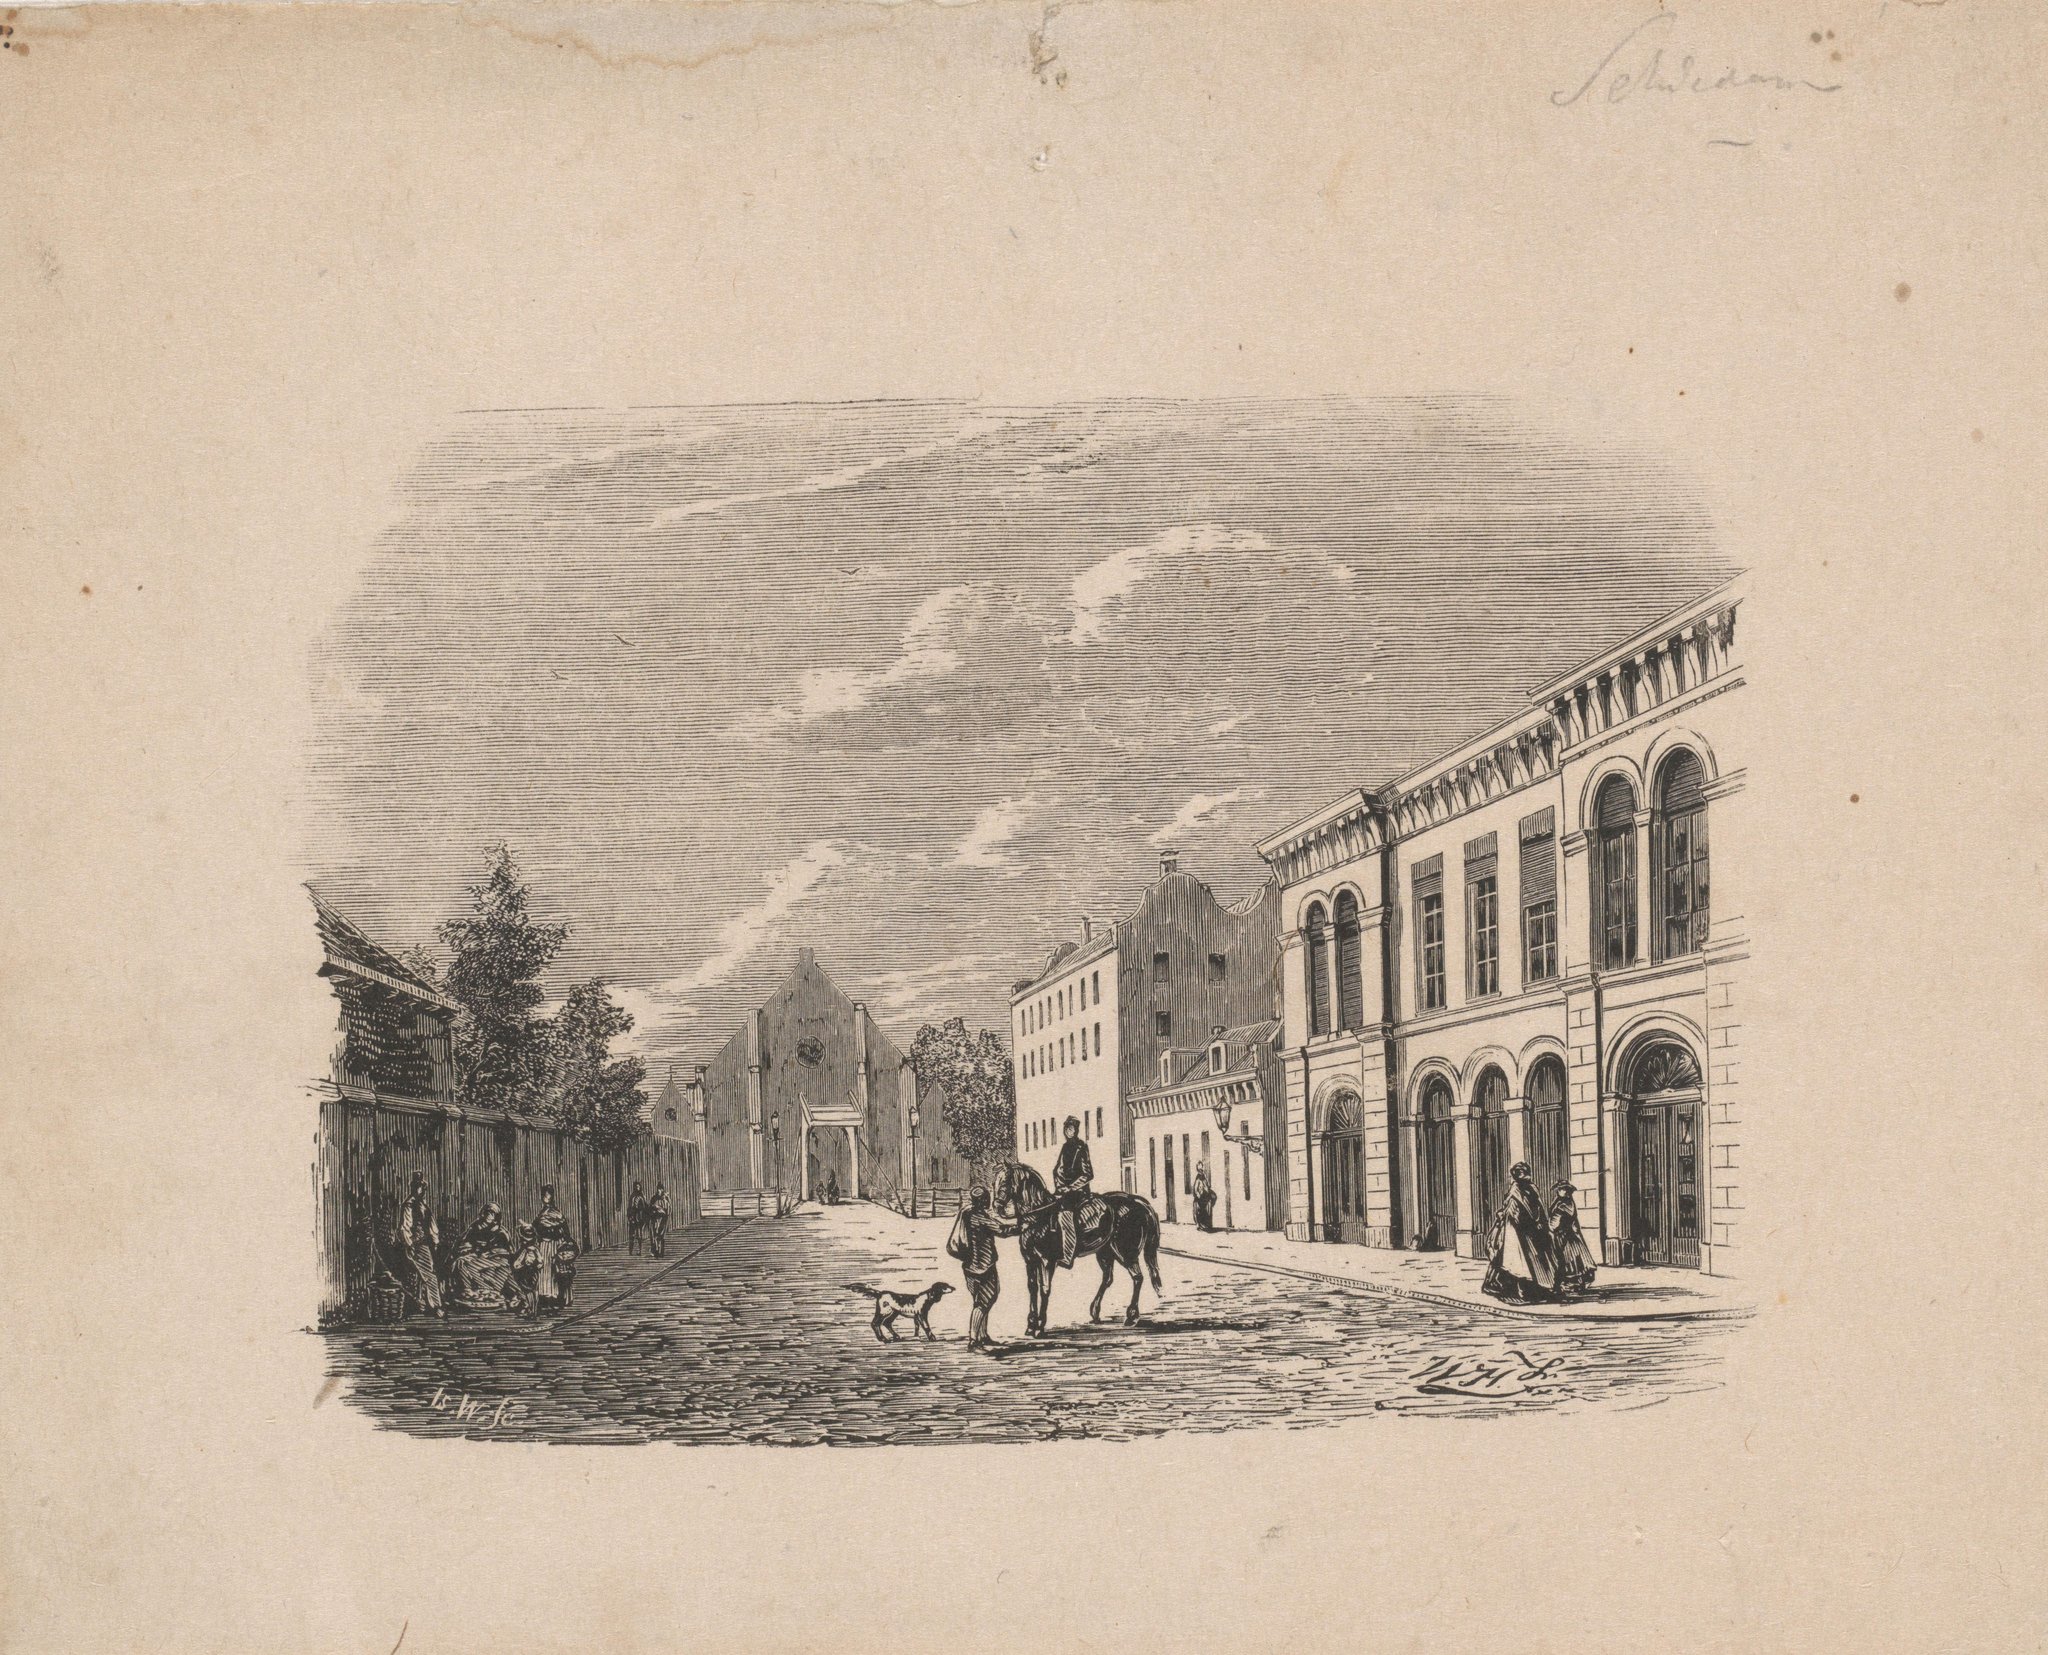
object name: print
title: Gezicht op een straat met een ophaalbrug te Schiedam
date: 1836-1912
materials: paper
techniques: engraving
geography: netherlands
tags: drawbridge ~ fortified city, horse, dog, street (+ city(-scape) with figures, staffage)